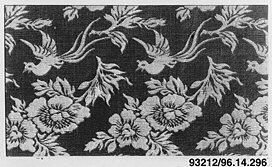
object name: piece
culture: japanese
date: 1701-1900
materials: silk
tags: flowers